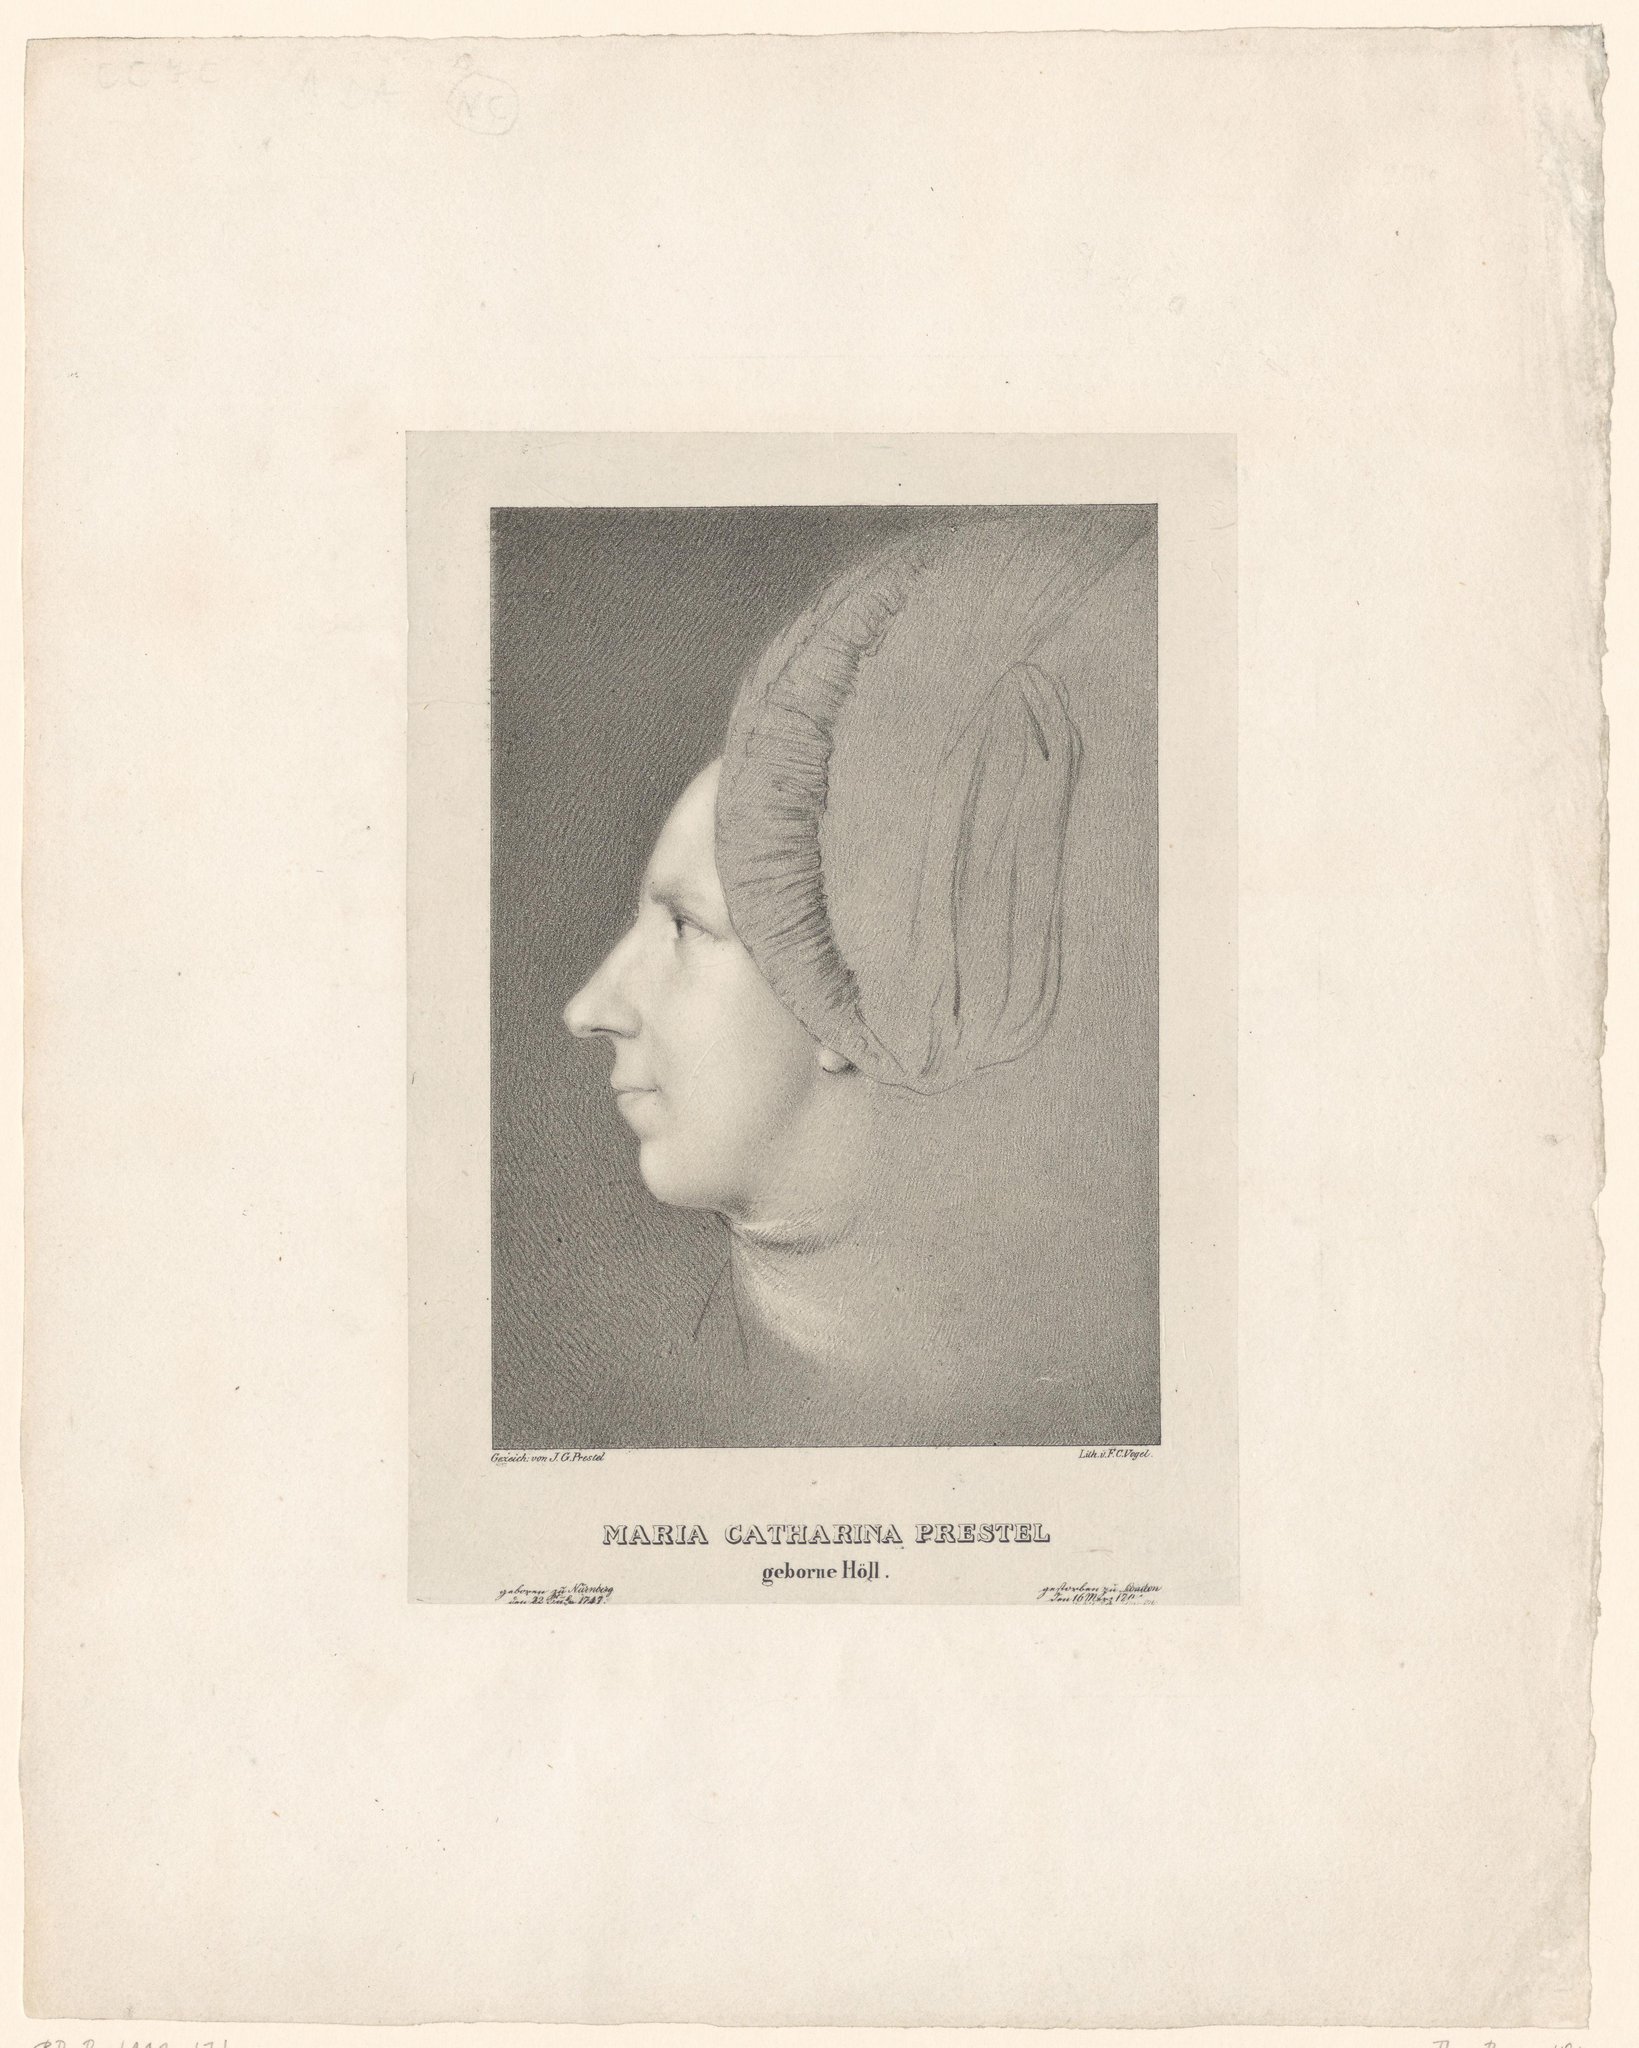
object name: print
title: Portret van Maria Catharina Prestel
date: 1794-1840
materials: paper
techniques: lithograph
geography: germany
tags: london, painter, maria catharina prestel, adult woman, head-gear, historical persons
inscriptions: collector's mark: Lugt 2760, collector's mark: Lugt 2228